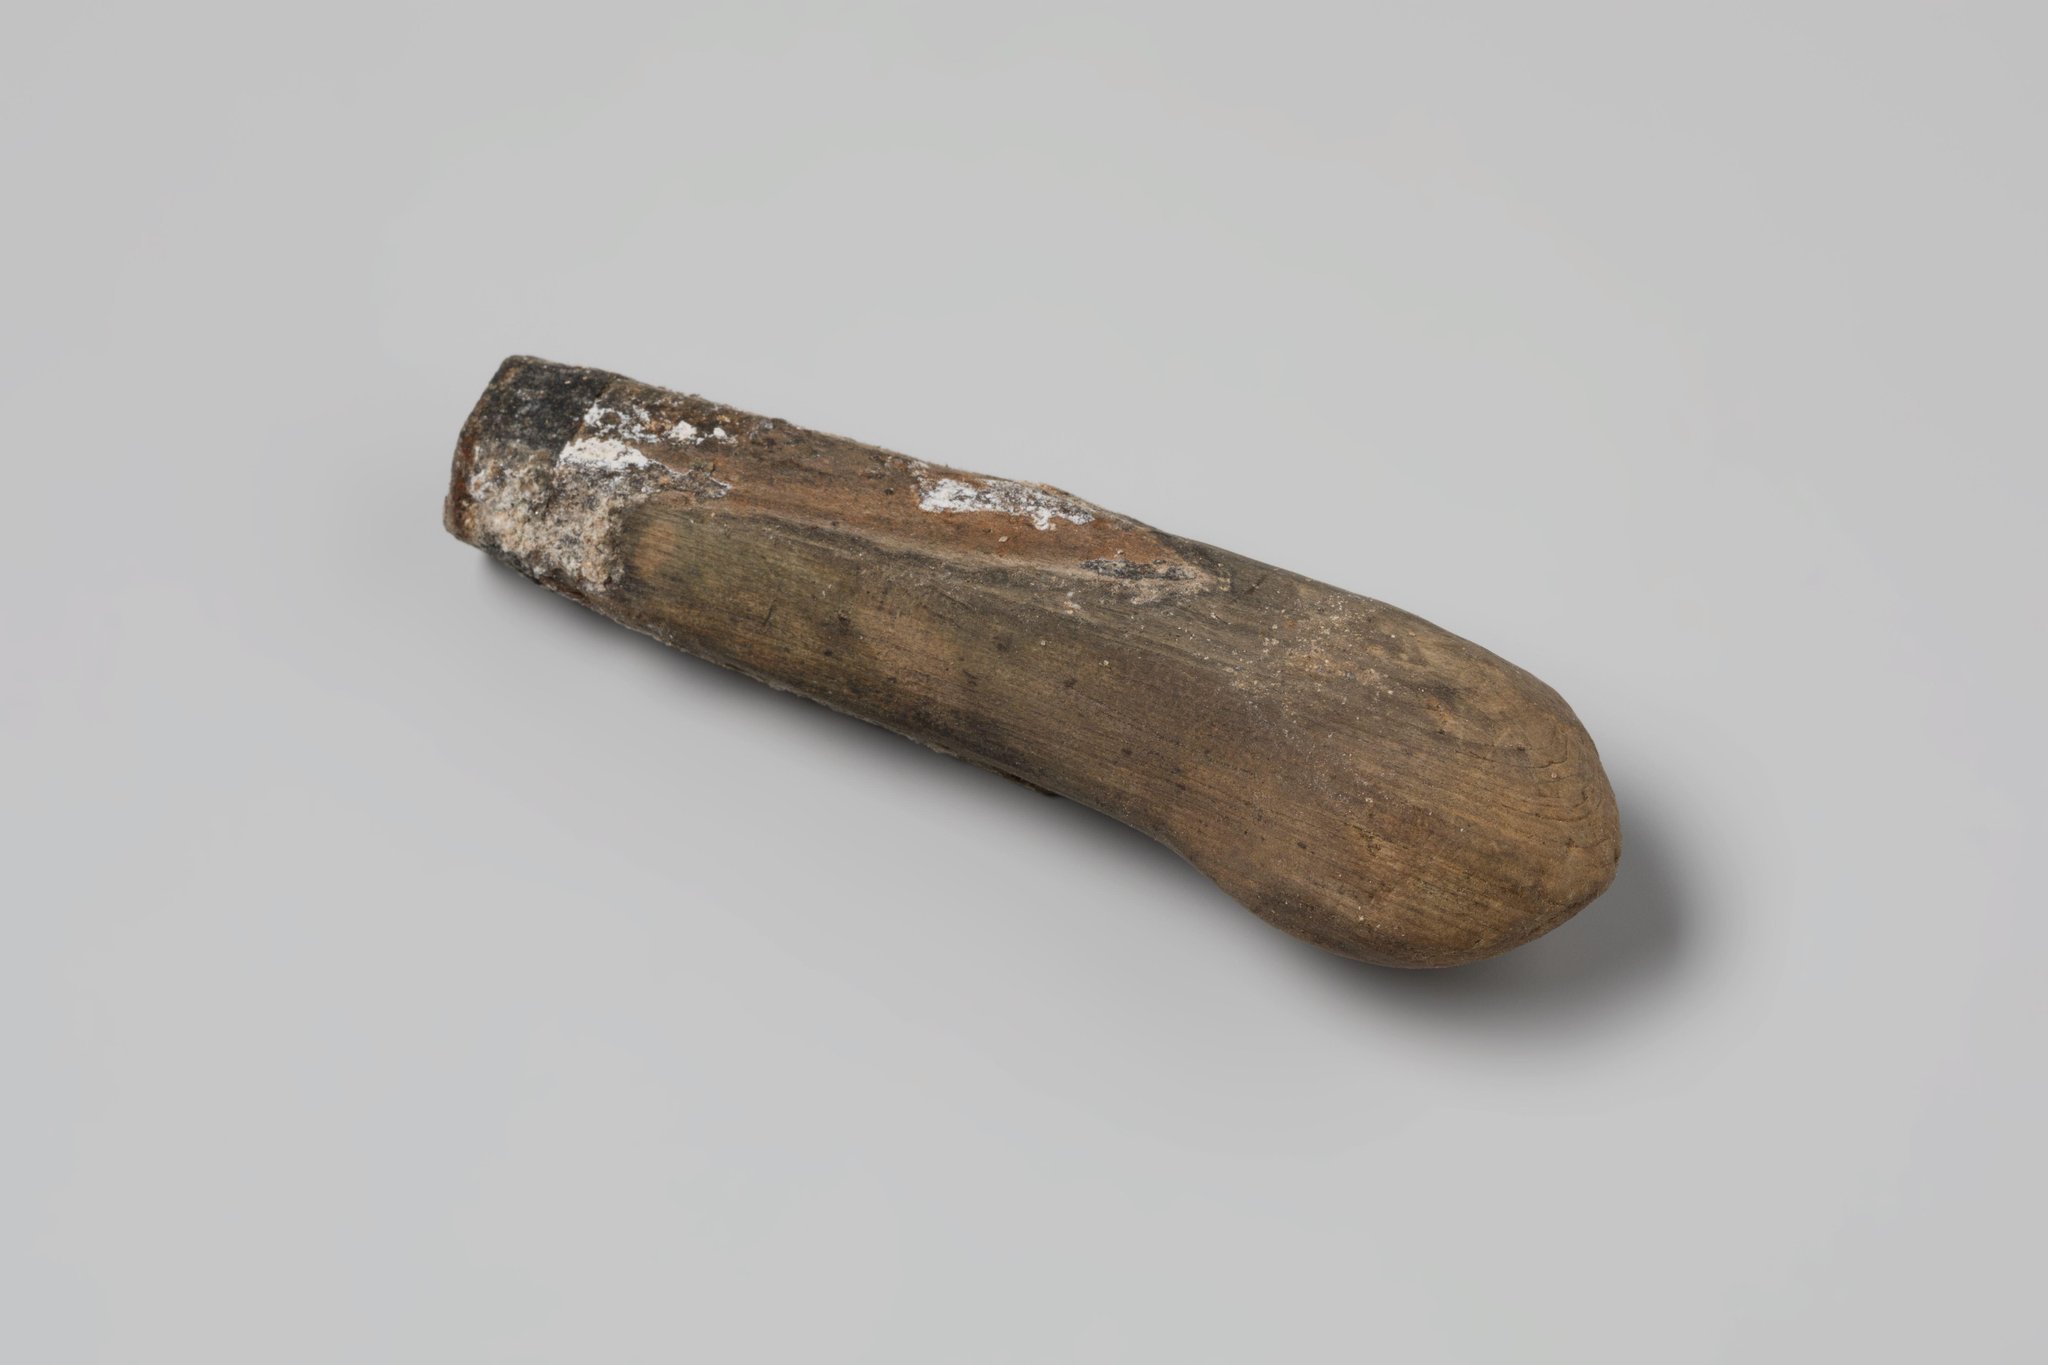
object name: knife tool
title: Messenheft uit het wrak van de Oost-Indiëvaarder Hollandia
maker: Anonymous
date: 1700-1743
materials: metal, wood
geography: netherlands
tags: verenigde oostindische compagnie, hollandia (schip), annet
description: Knive, pistol-grip-shaped hexagonal faceted, tapering, slightly pointed upper end, ferrule.